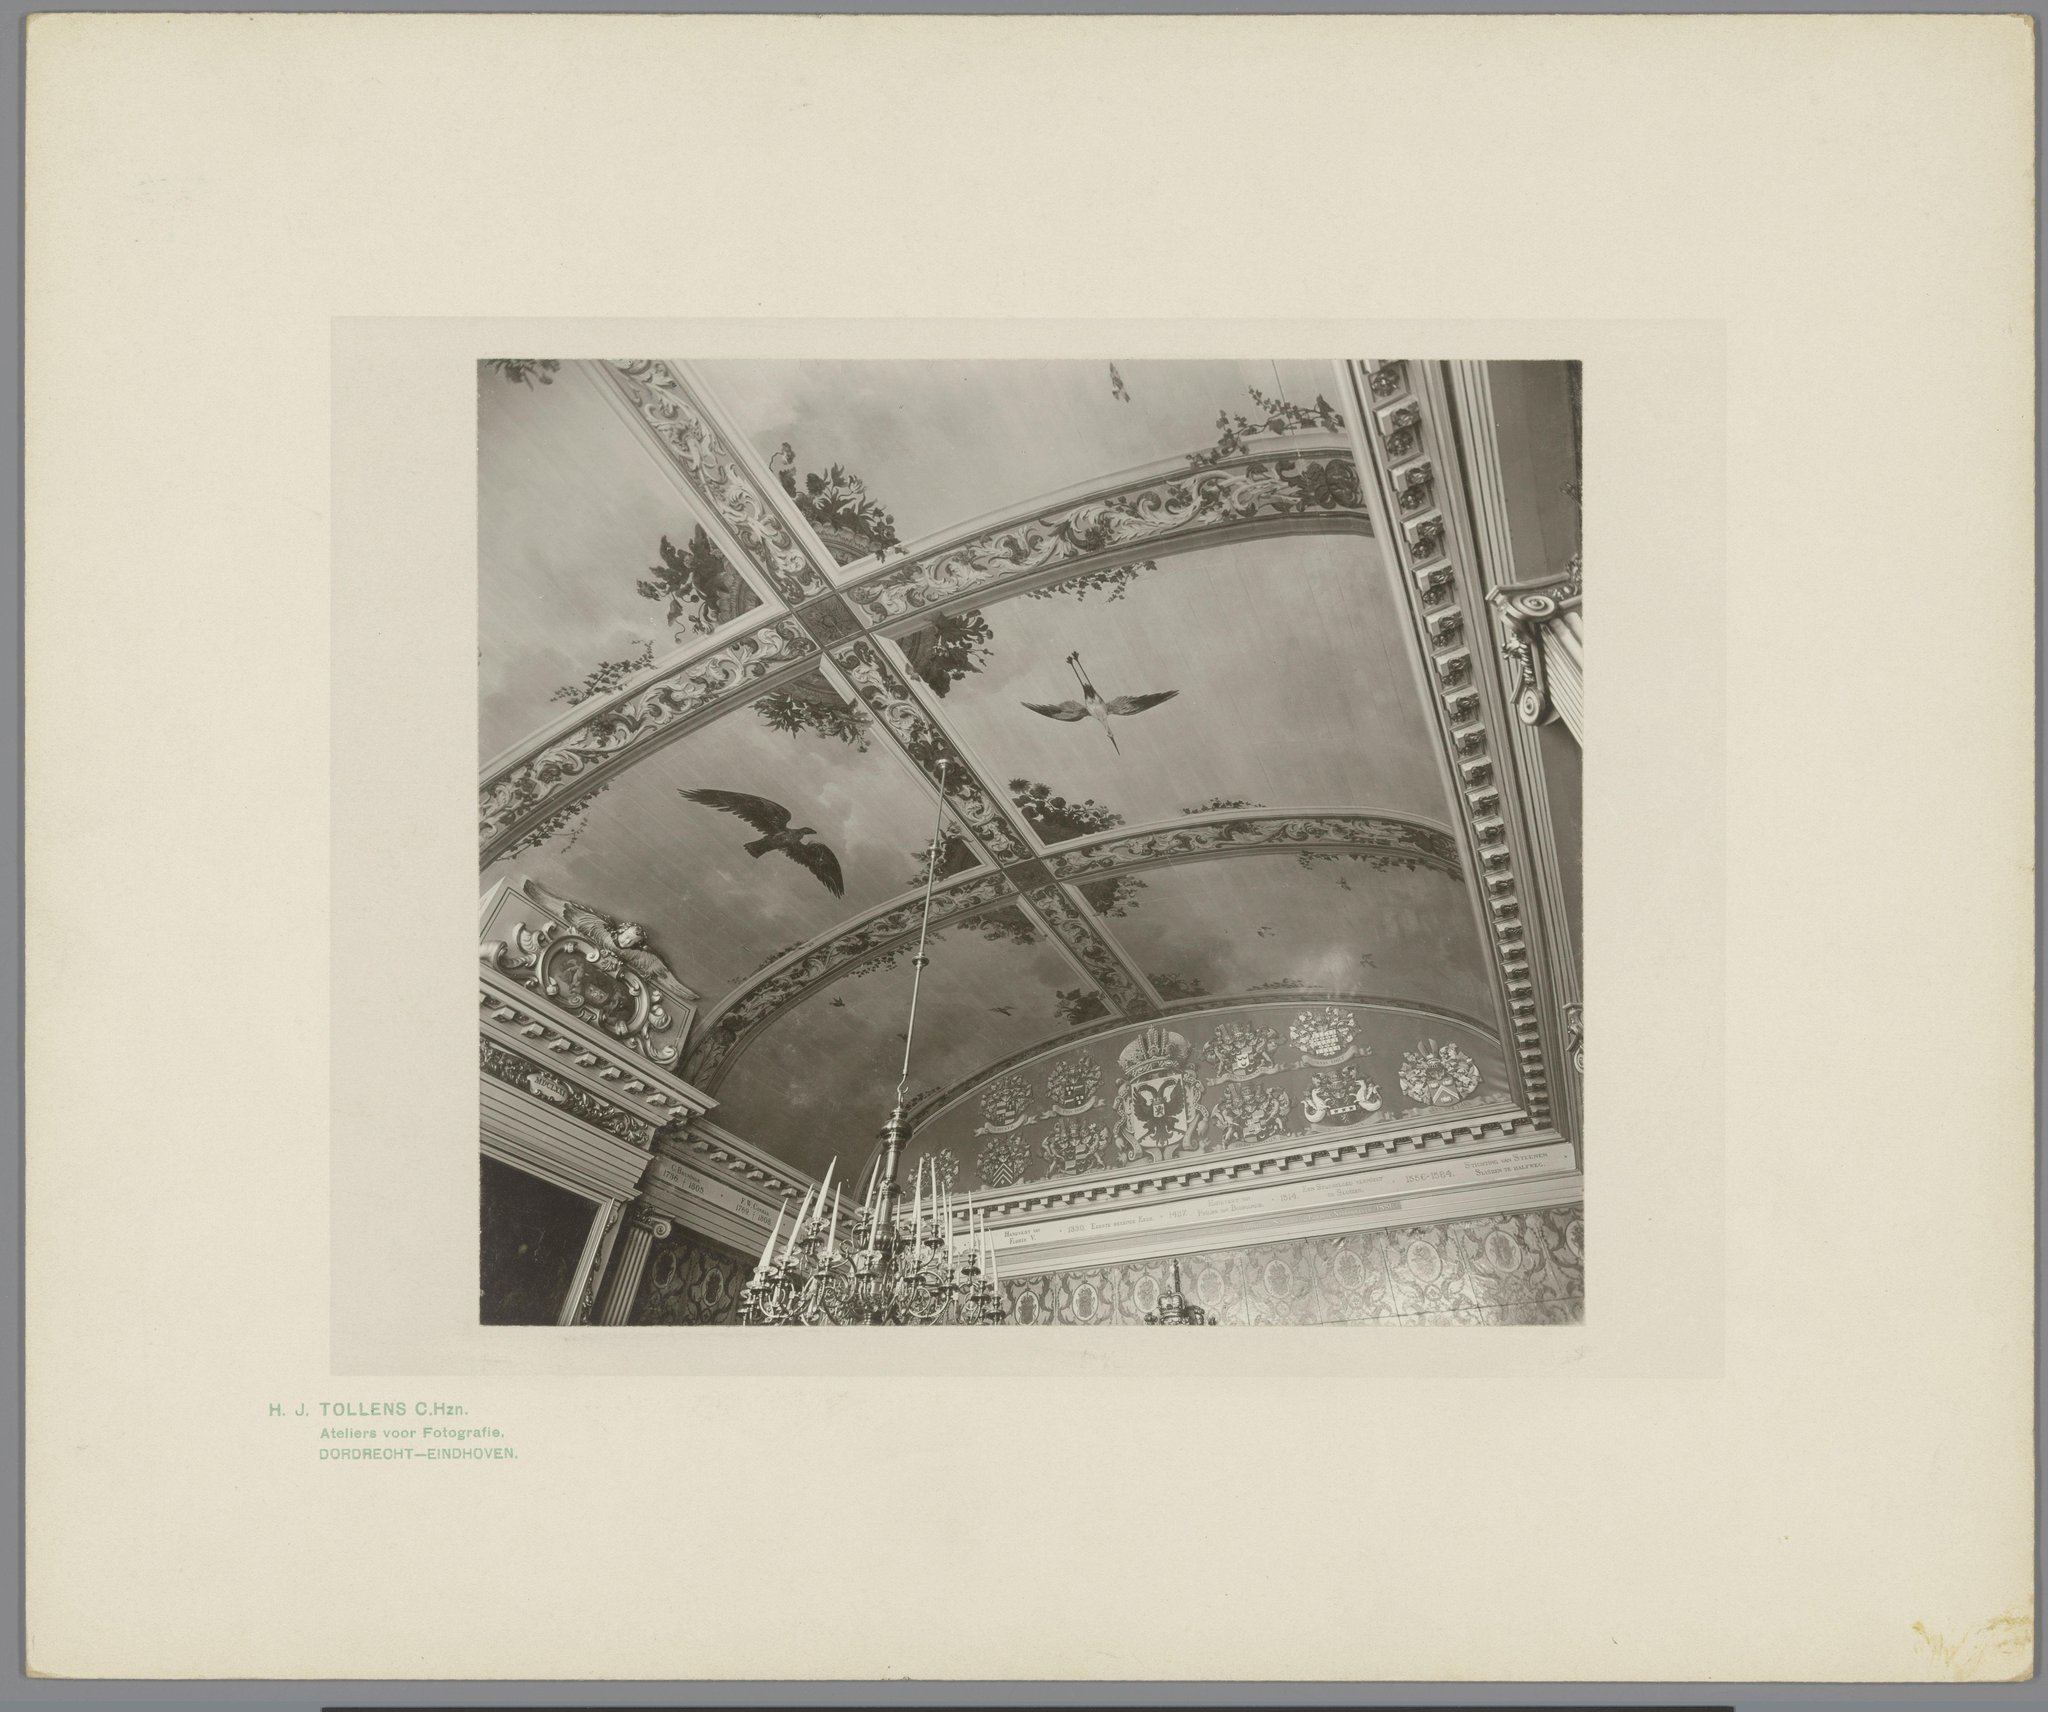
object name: photograph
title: Plafond van een kamer in het Rijnlandshuis te Leiden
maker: henricus jacobus tollens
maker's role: painter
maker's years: 1864-1936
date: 1880-1910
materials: cardboard, photographic support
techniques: collodion silver print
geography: leiden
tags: interior of the house, (decorated) ceiling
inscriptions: inscription: ‘H.J. Tollens C. Hzn./ Ateliers voor Fotografie/ Dordrecht-Eindhoven’, annotation: ‘Leiden’